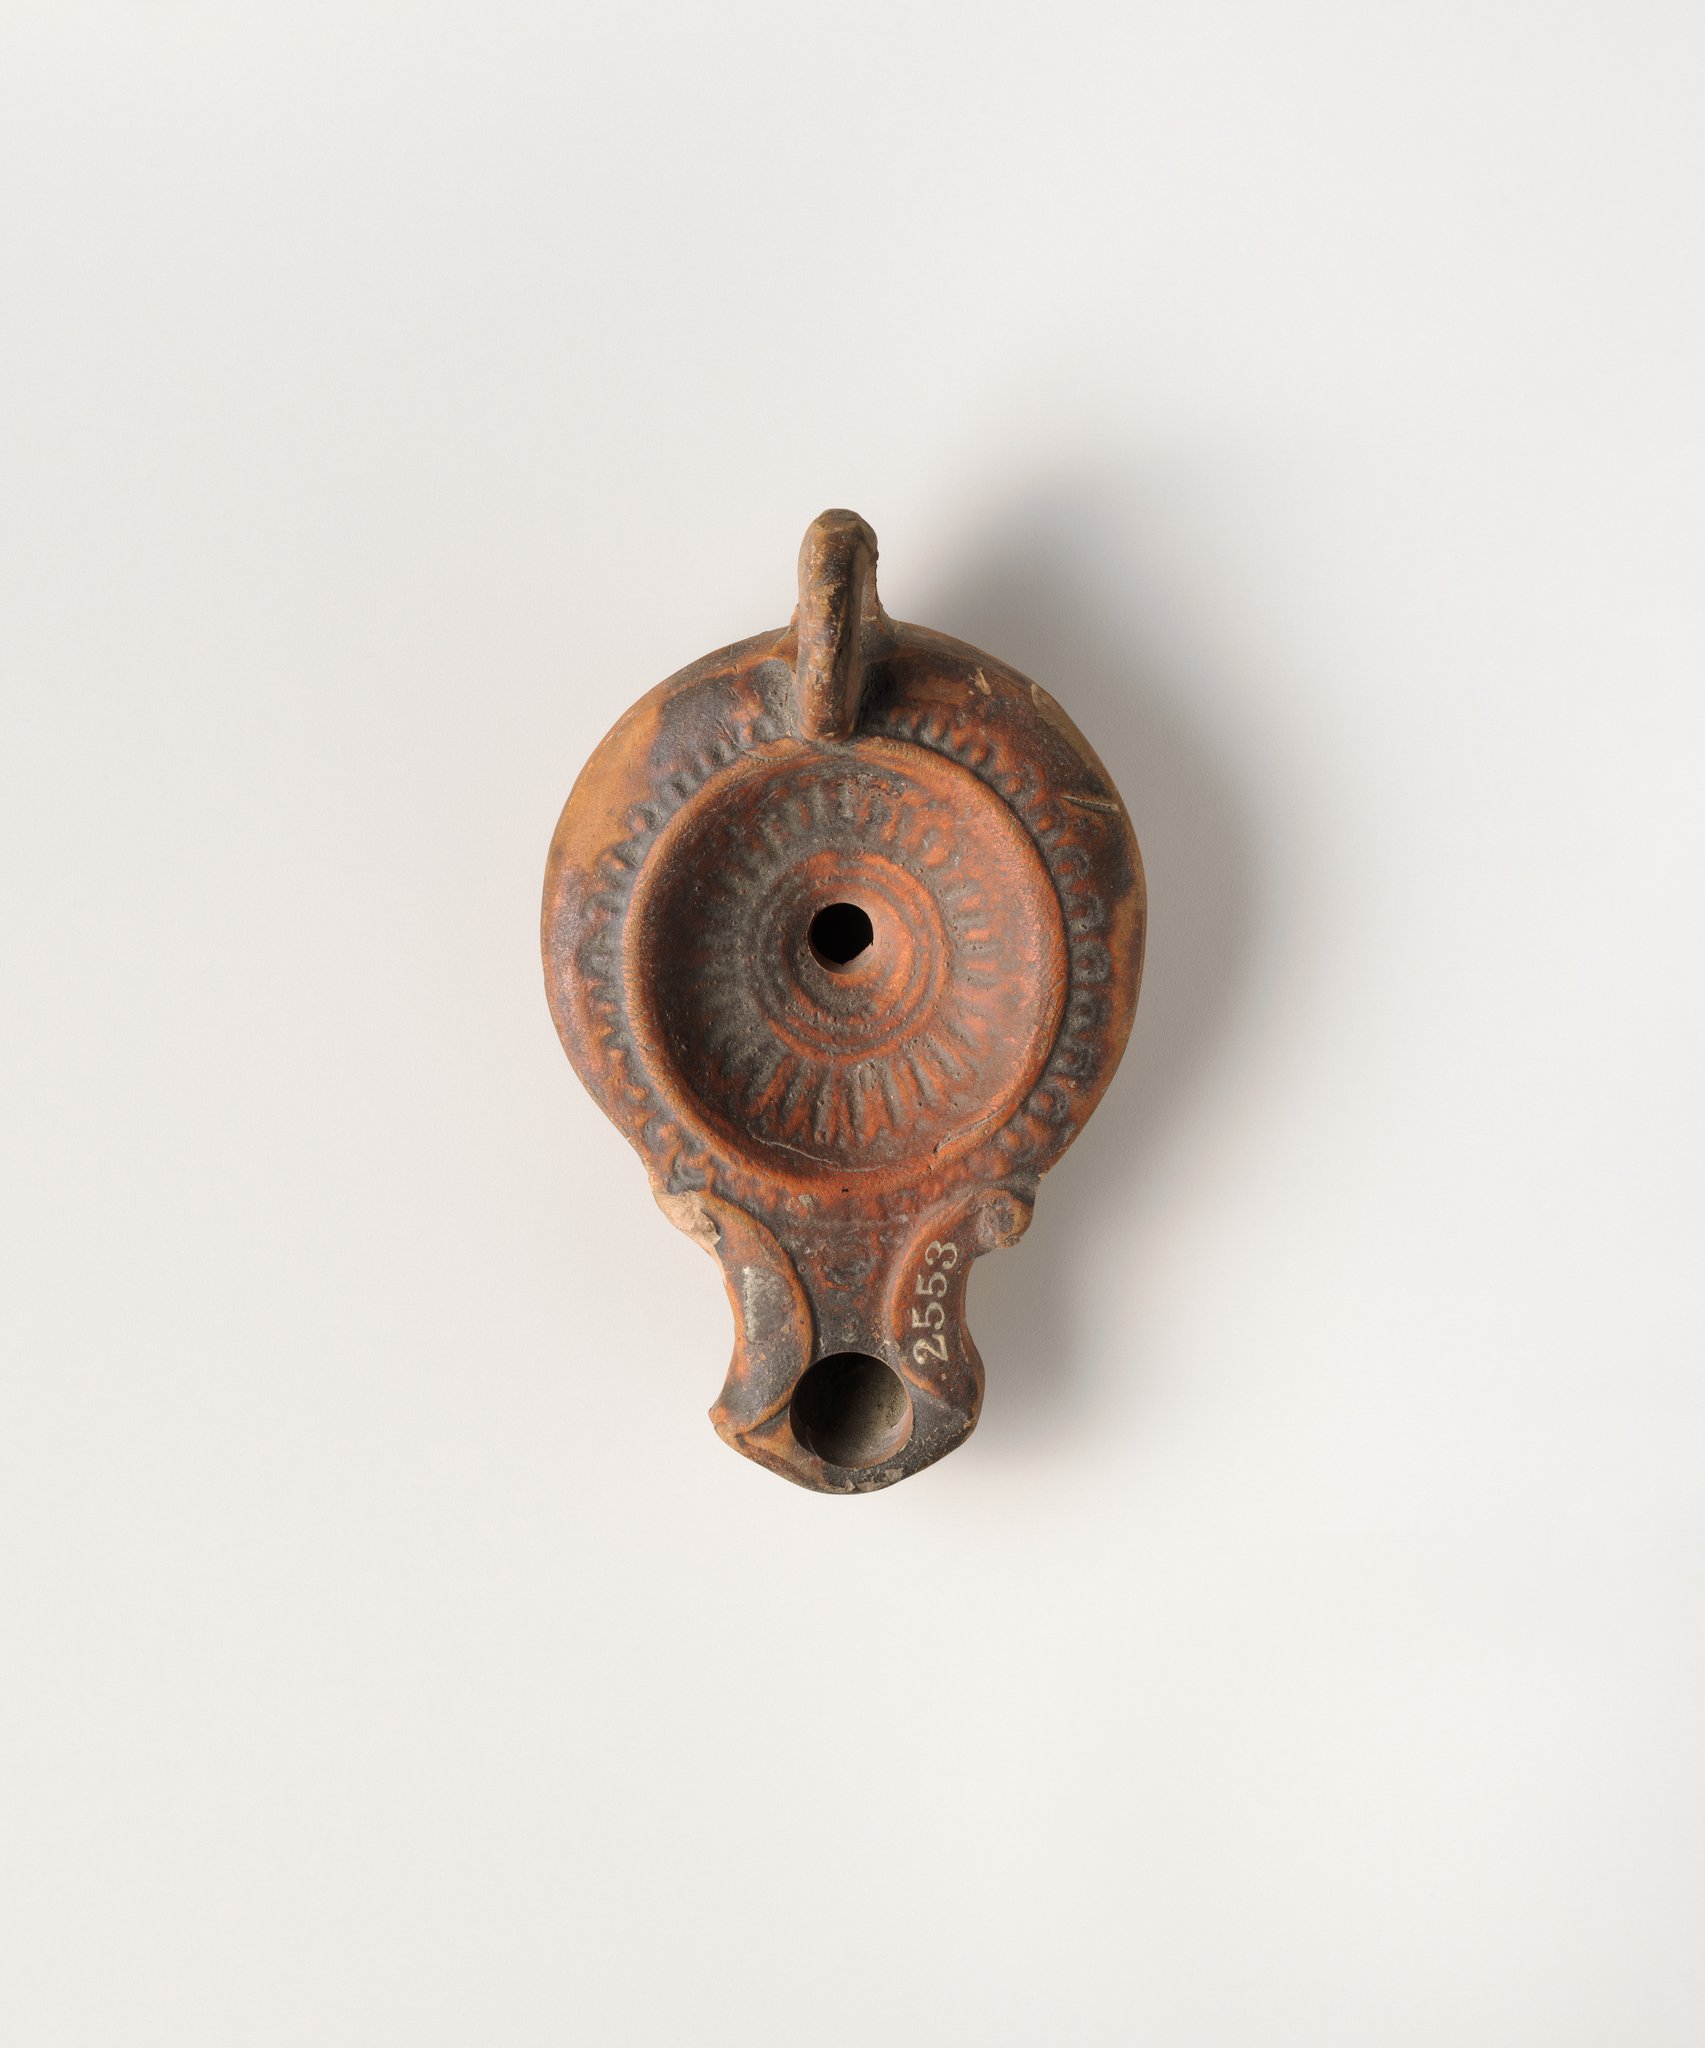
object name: lamp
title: Terracotta oil lamp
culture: roman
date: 100 BCE-100 CE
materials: terracotta